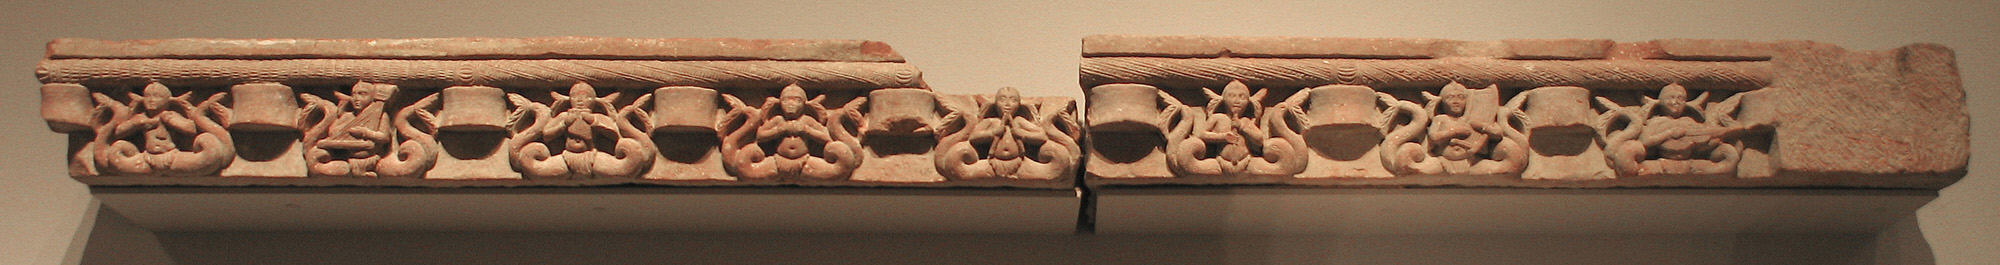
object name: architectural frieze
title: Architectural Frieze with Merman Playing Musical Instruments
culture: indian, uttar pradesh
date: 101-300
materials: stone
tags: kushan,mathura